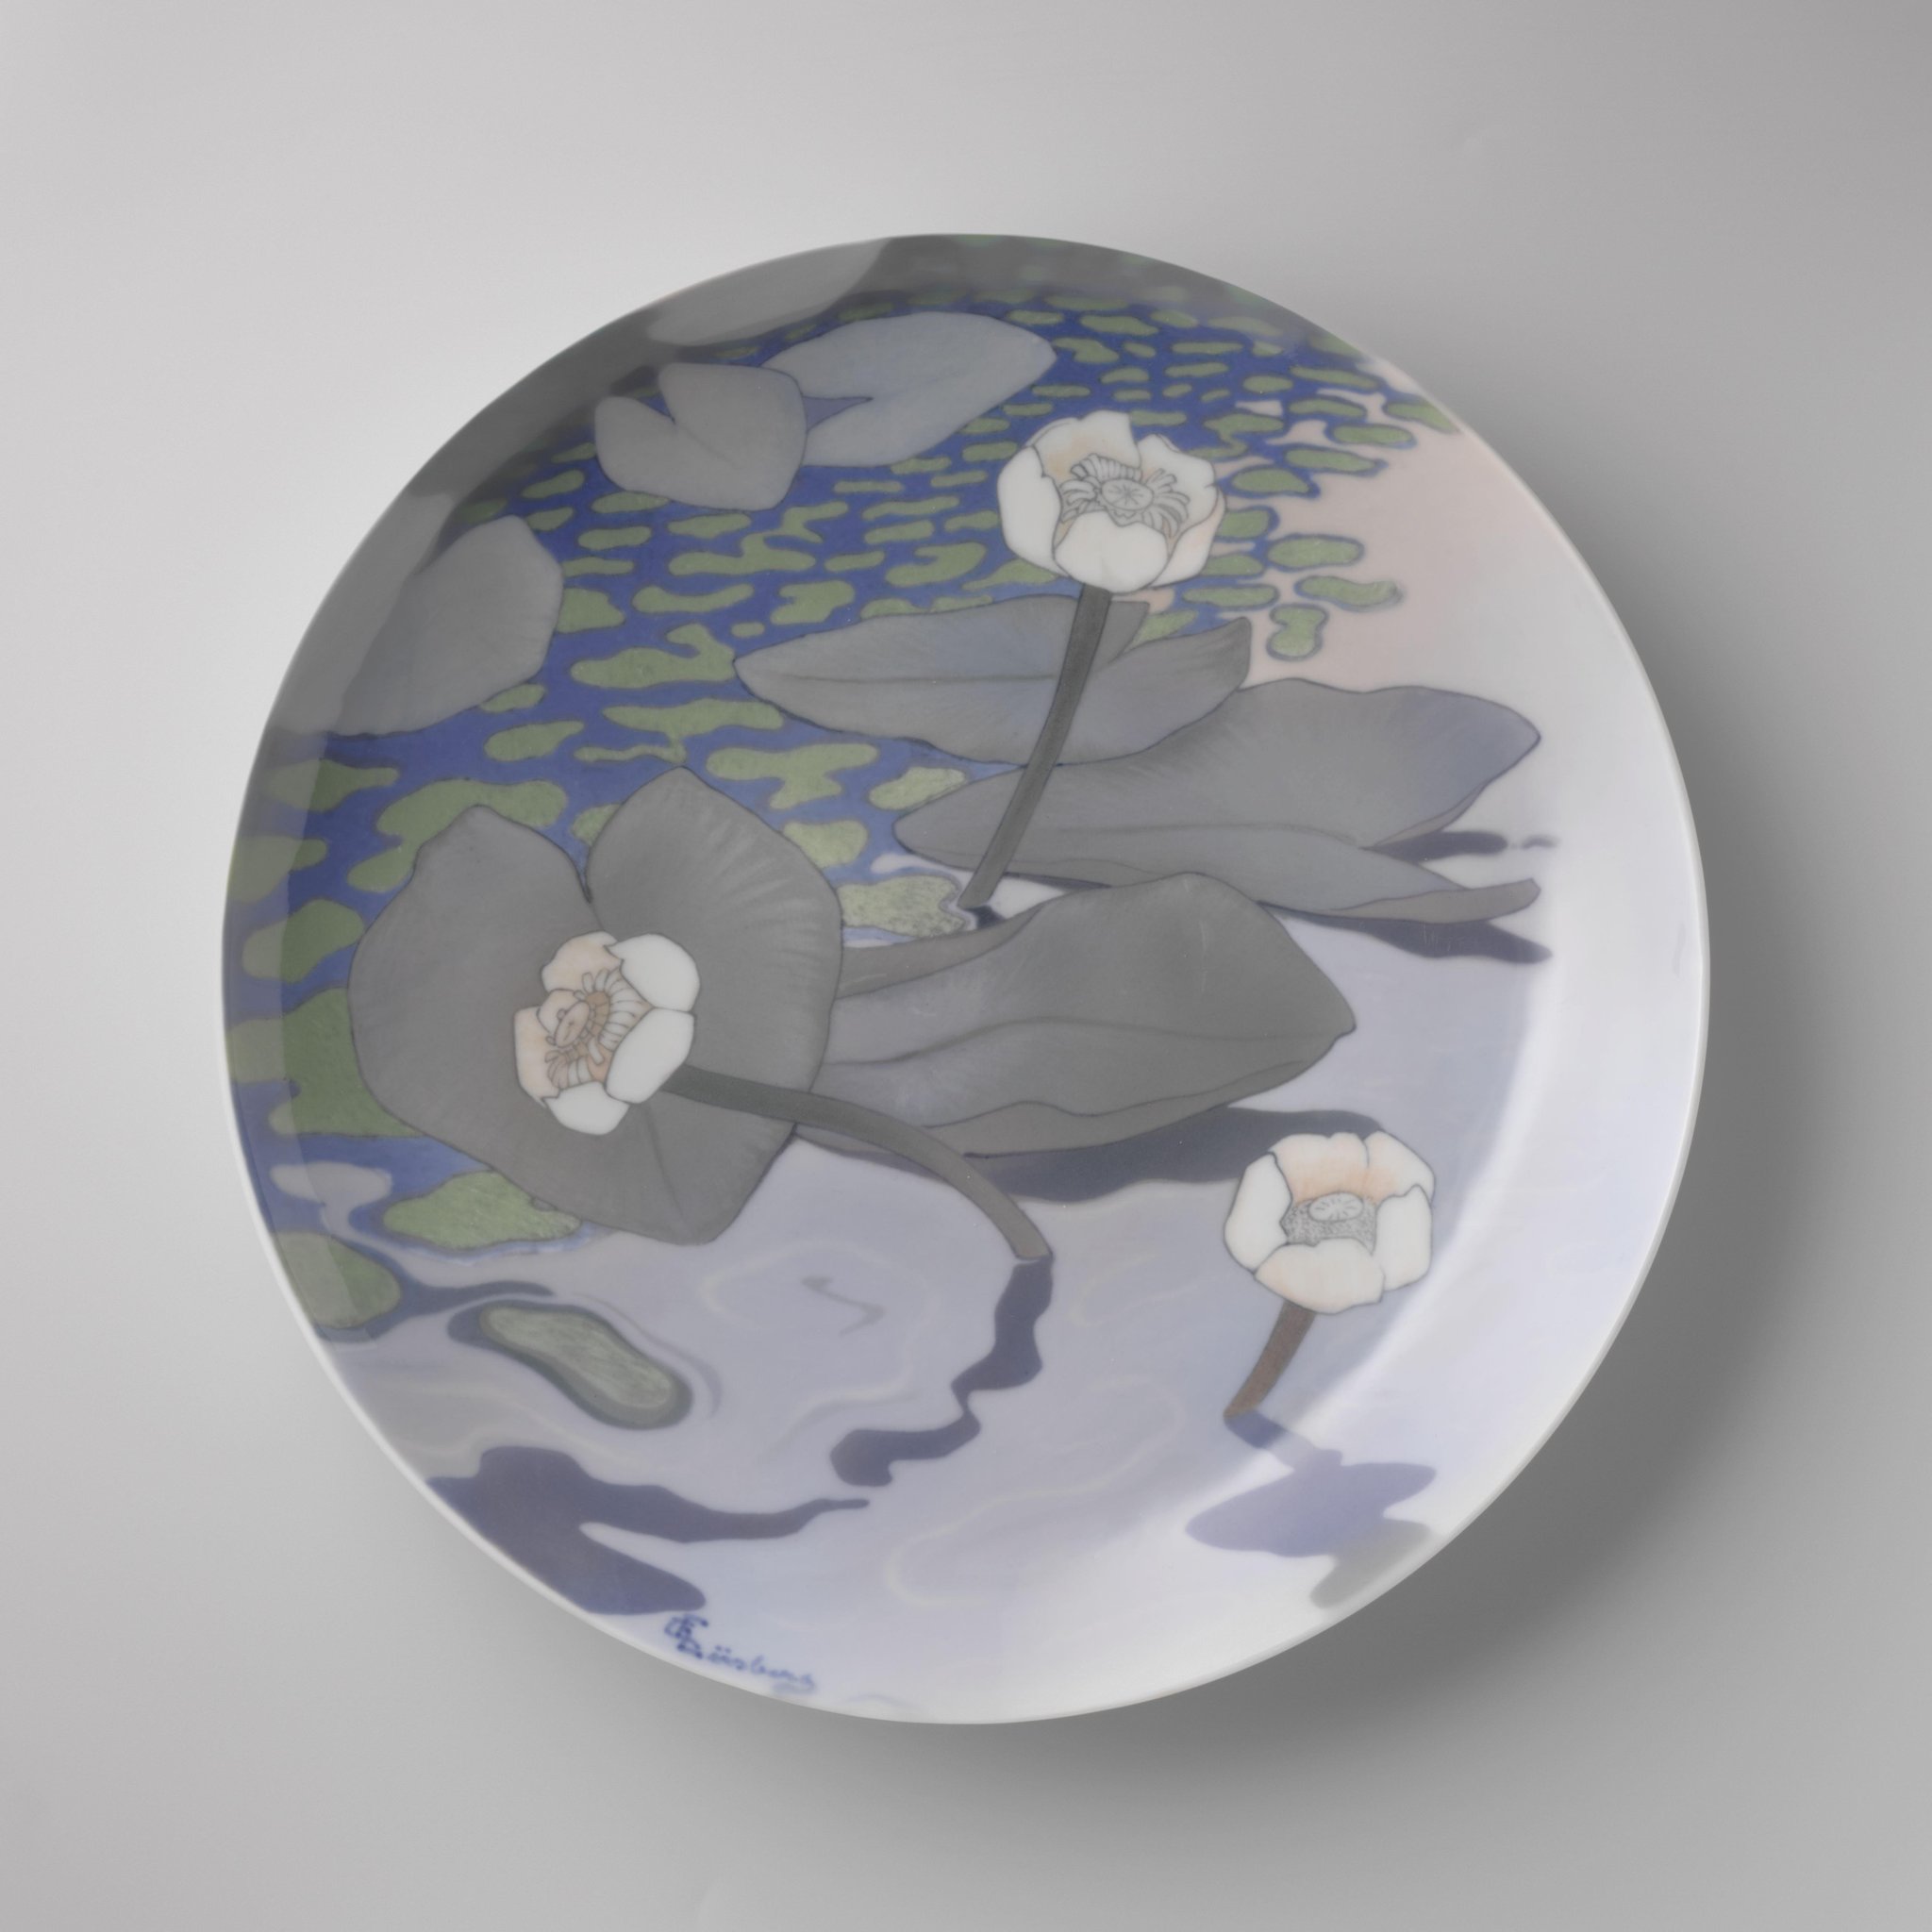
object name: platter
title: Schotel met decoratie gele plomp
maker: carl frederik liisberg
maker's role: sculptor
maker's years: 1860-1909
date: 1808-1897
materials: porcelain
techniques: painted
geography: copenhagen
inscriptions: mark: ‘in onderglazuurblauw: drie golflijnen, N.8 en monogram CFL en getal 6387; ingegrifte sierlijke letter V (binnen voetring) op ongeglazuurde achterzijde’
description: Dish. Porcelain. Copenhagen, Den Kongelig Porcelainfabrik, 1897, designed by Carl Frederik Liisberg.